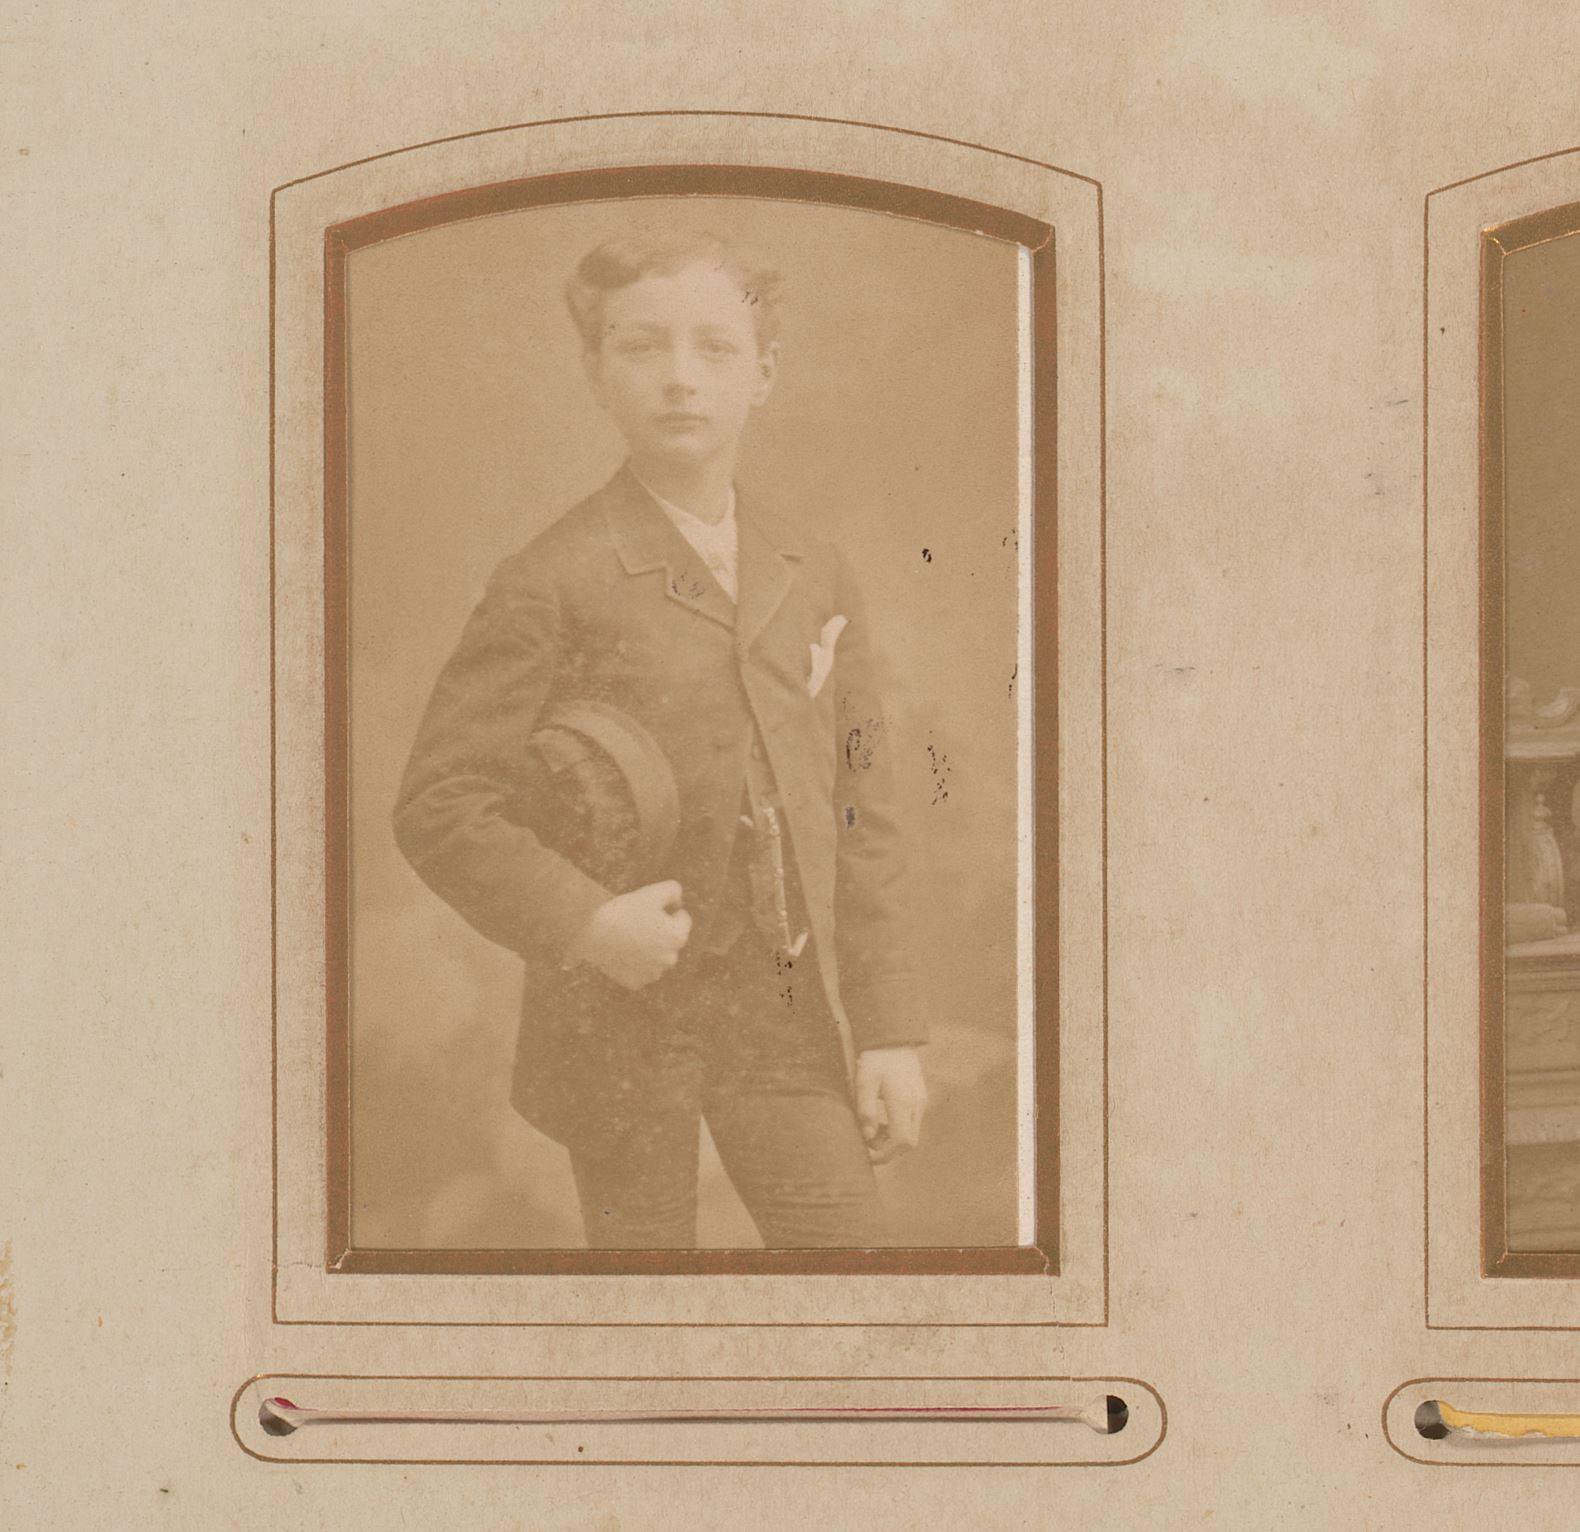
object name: album leaf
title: Portret van een staande jongen met pet onder de arm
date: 1889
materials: cardboard, photographic support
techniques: albumen print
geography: antwerp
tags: boy (child between toddler and youth), historical persons, head-gear: cap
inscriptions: dedication: ‘Souvernir d'amitié/ Fernand [K...]/ Louvain le 1 Janvier/ 1889.’, name: ‘Richard et L. Renard/ Anvers’